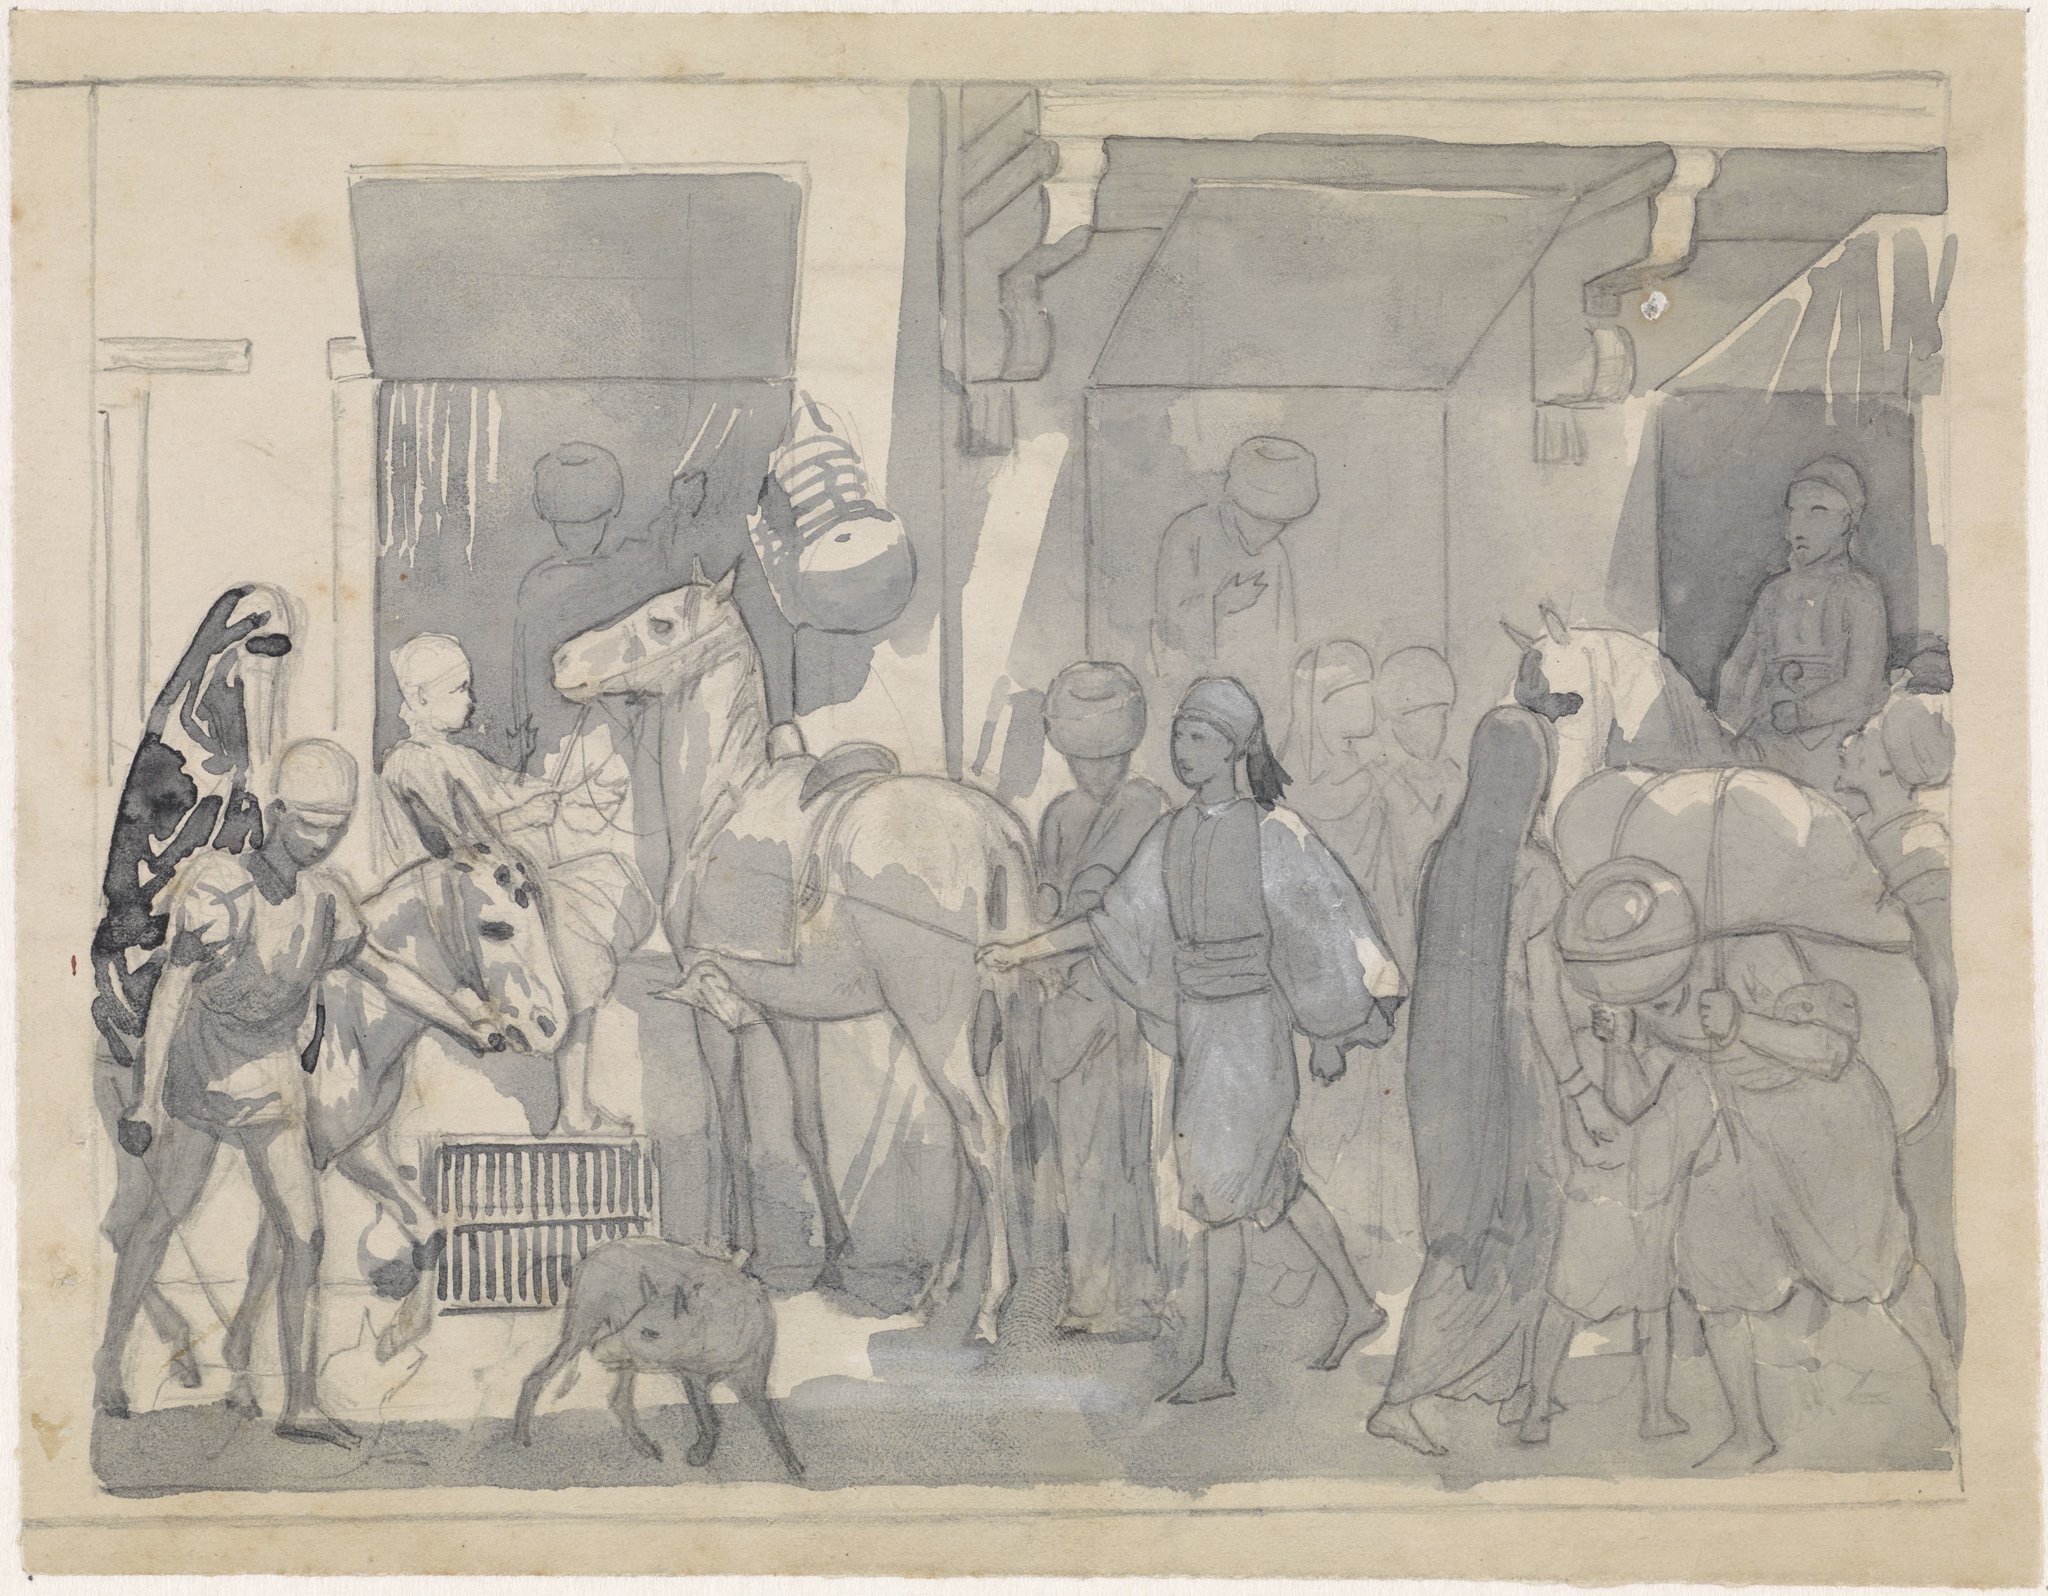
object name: drawing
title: Egyptisch straattafereel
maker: willem de famars testas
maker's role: draughtsman, painter, print maker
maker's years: 1834-1896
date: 1844-1896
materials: paper, pencil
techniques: brush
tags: street